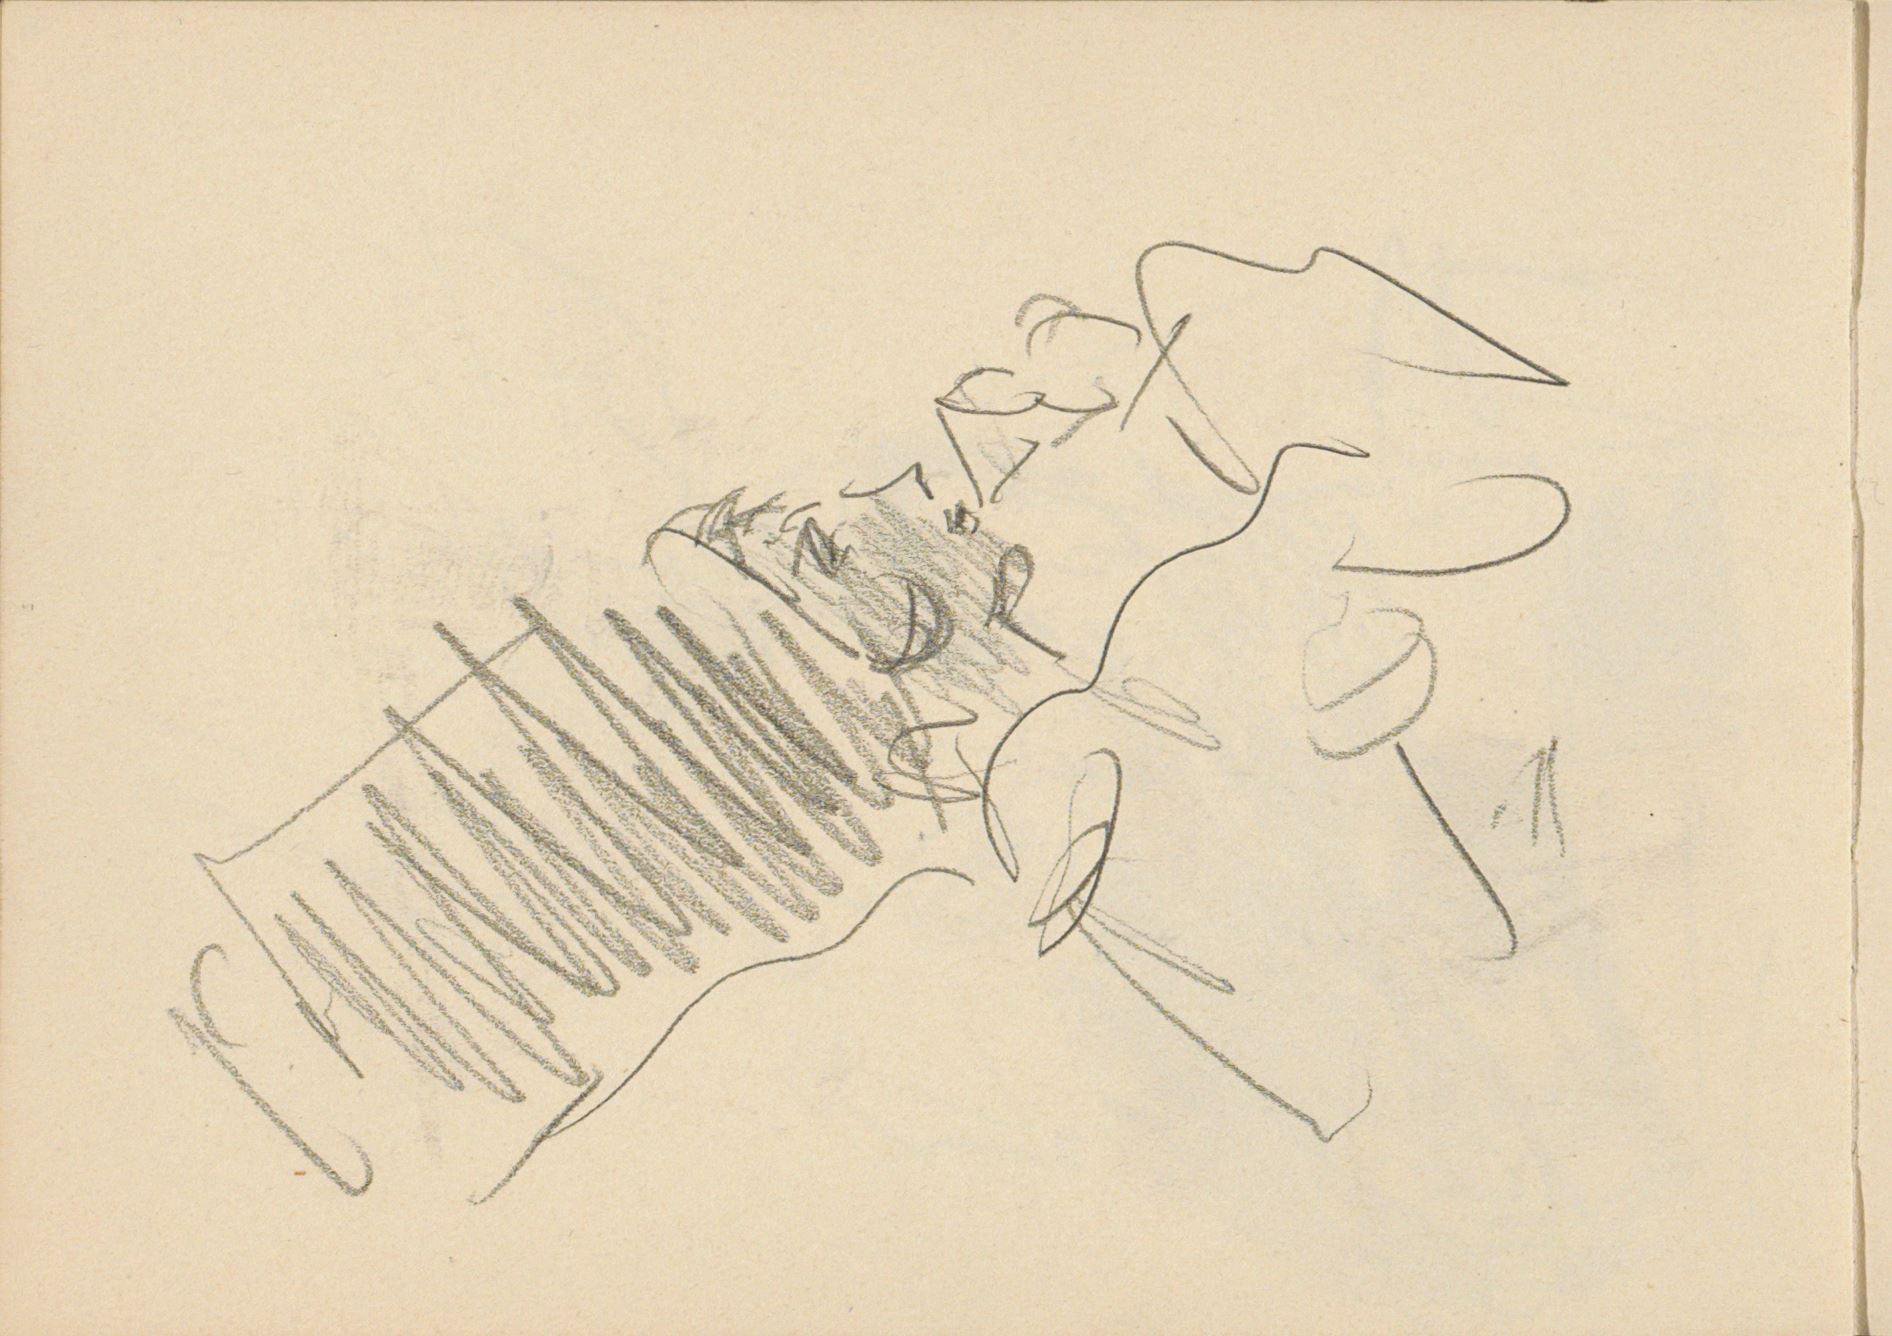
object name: sketchbook leaf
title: Vrouw met hoofdtooi, in profiel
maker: isaac israels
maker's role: draughtsman, painter, print maker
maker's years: 1865-1934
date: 1930-1934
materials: paper, pencil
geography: the hague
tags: performer, artiste (non-work situations), head-gear (+ women's clothes), adult woman (+ sideview, profile), drinking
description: Ze drinkt mogelijk uit een glas. Pagina 25 uit schetsboek XXXVIII met 45 pagina's.